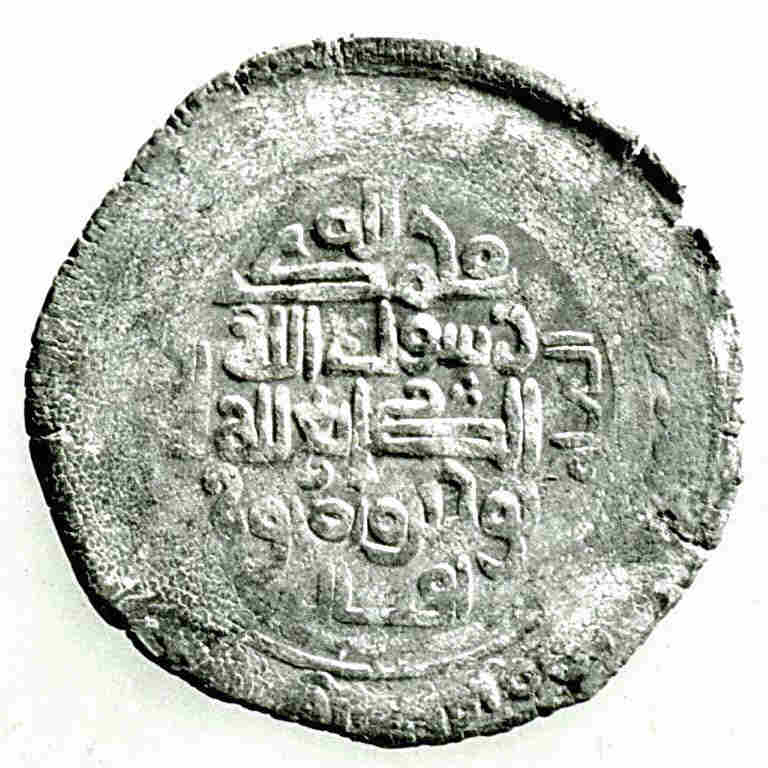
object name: coin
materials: silver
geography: iran